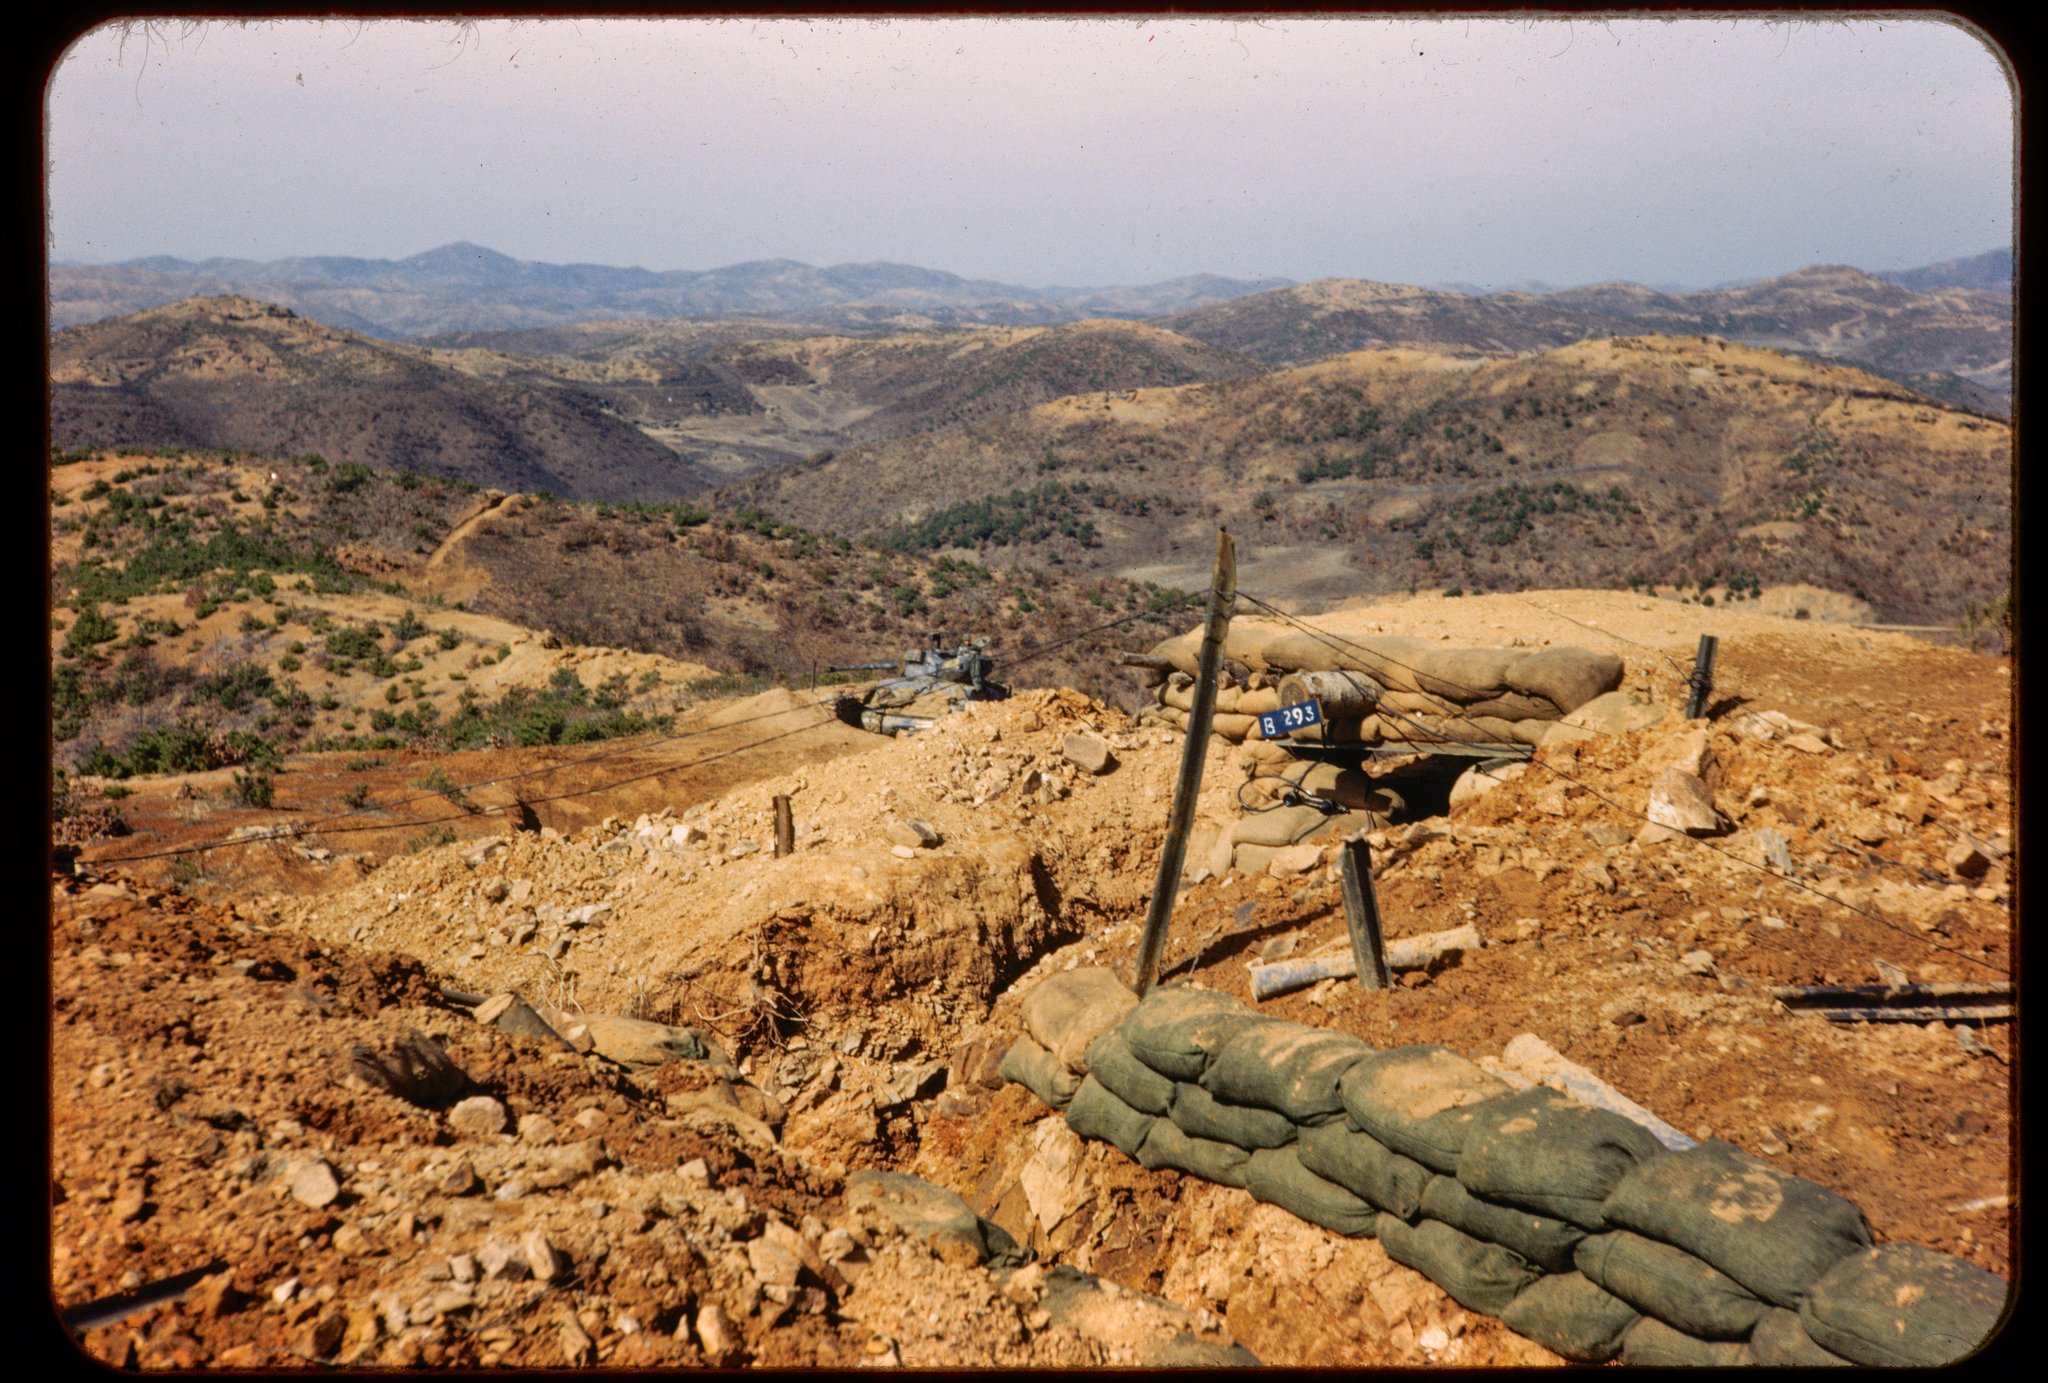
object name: color slide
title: Front in Korea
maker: david ketel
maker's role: diplomaat, sinoloog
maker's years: 1913-2008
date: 1952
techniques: slide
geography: korea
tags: united nations